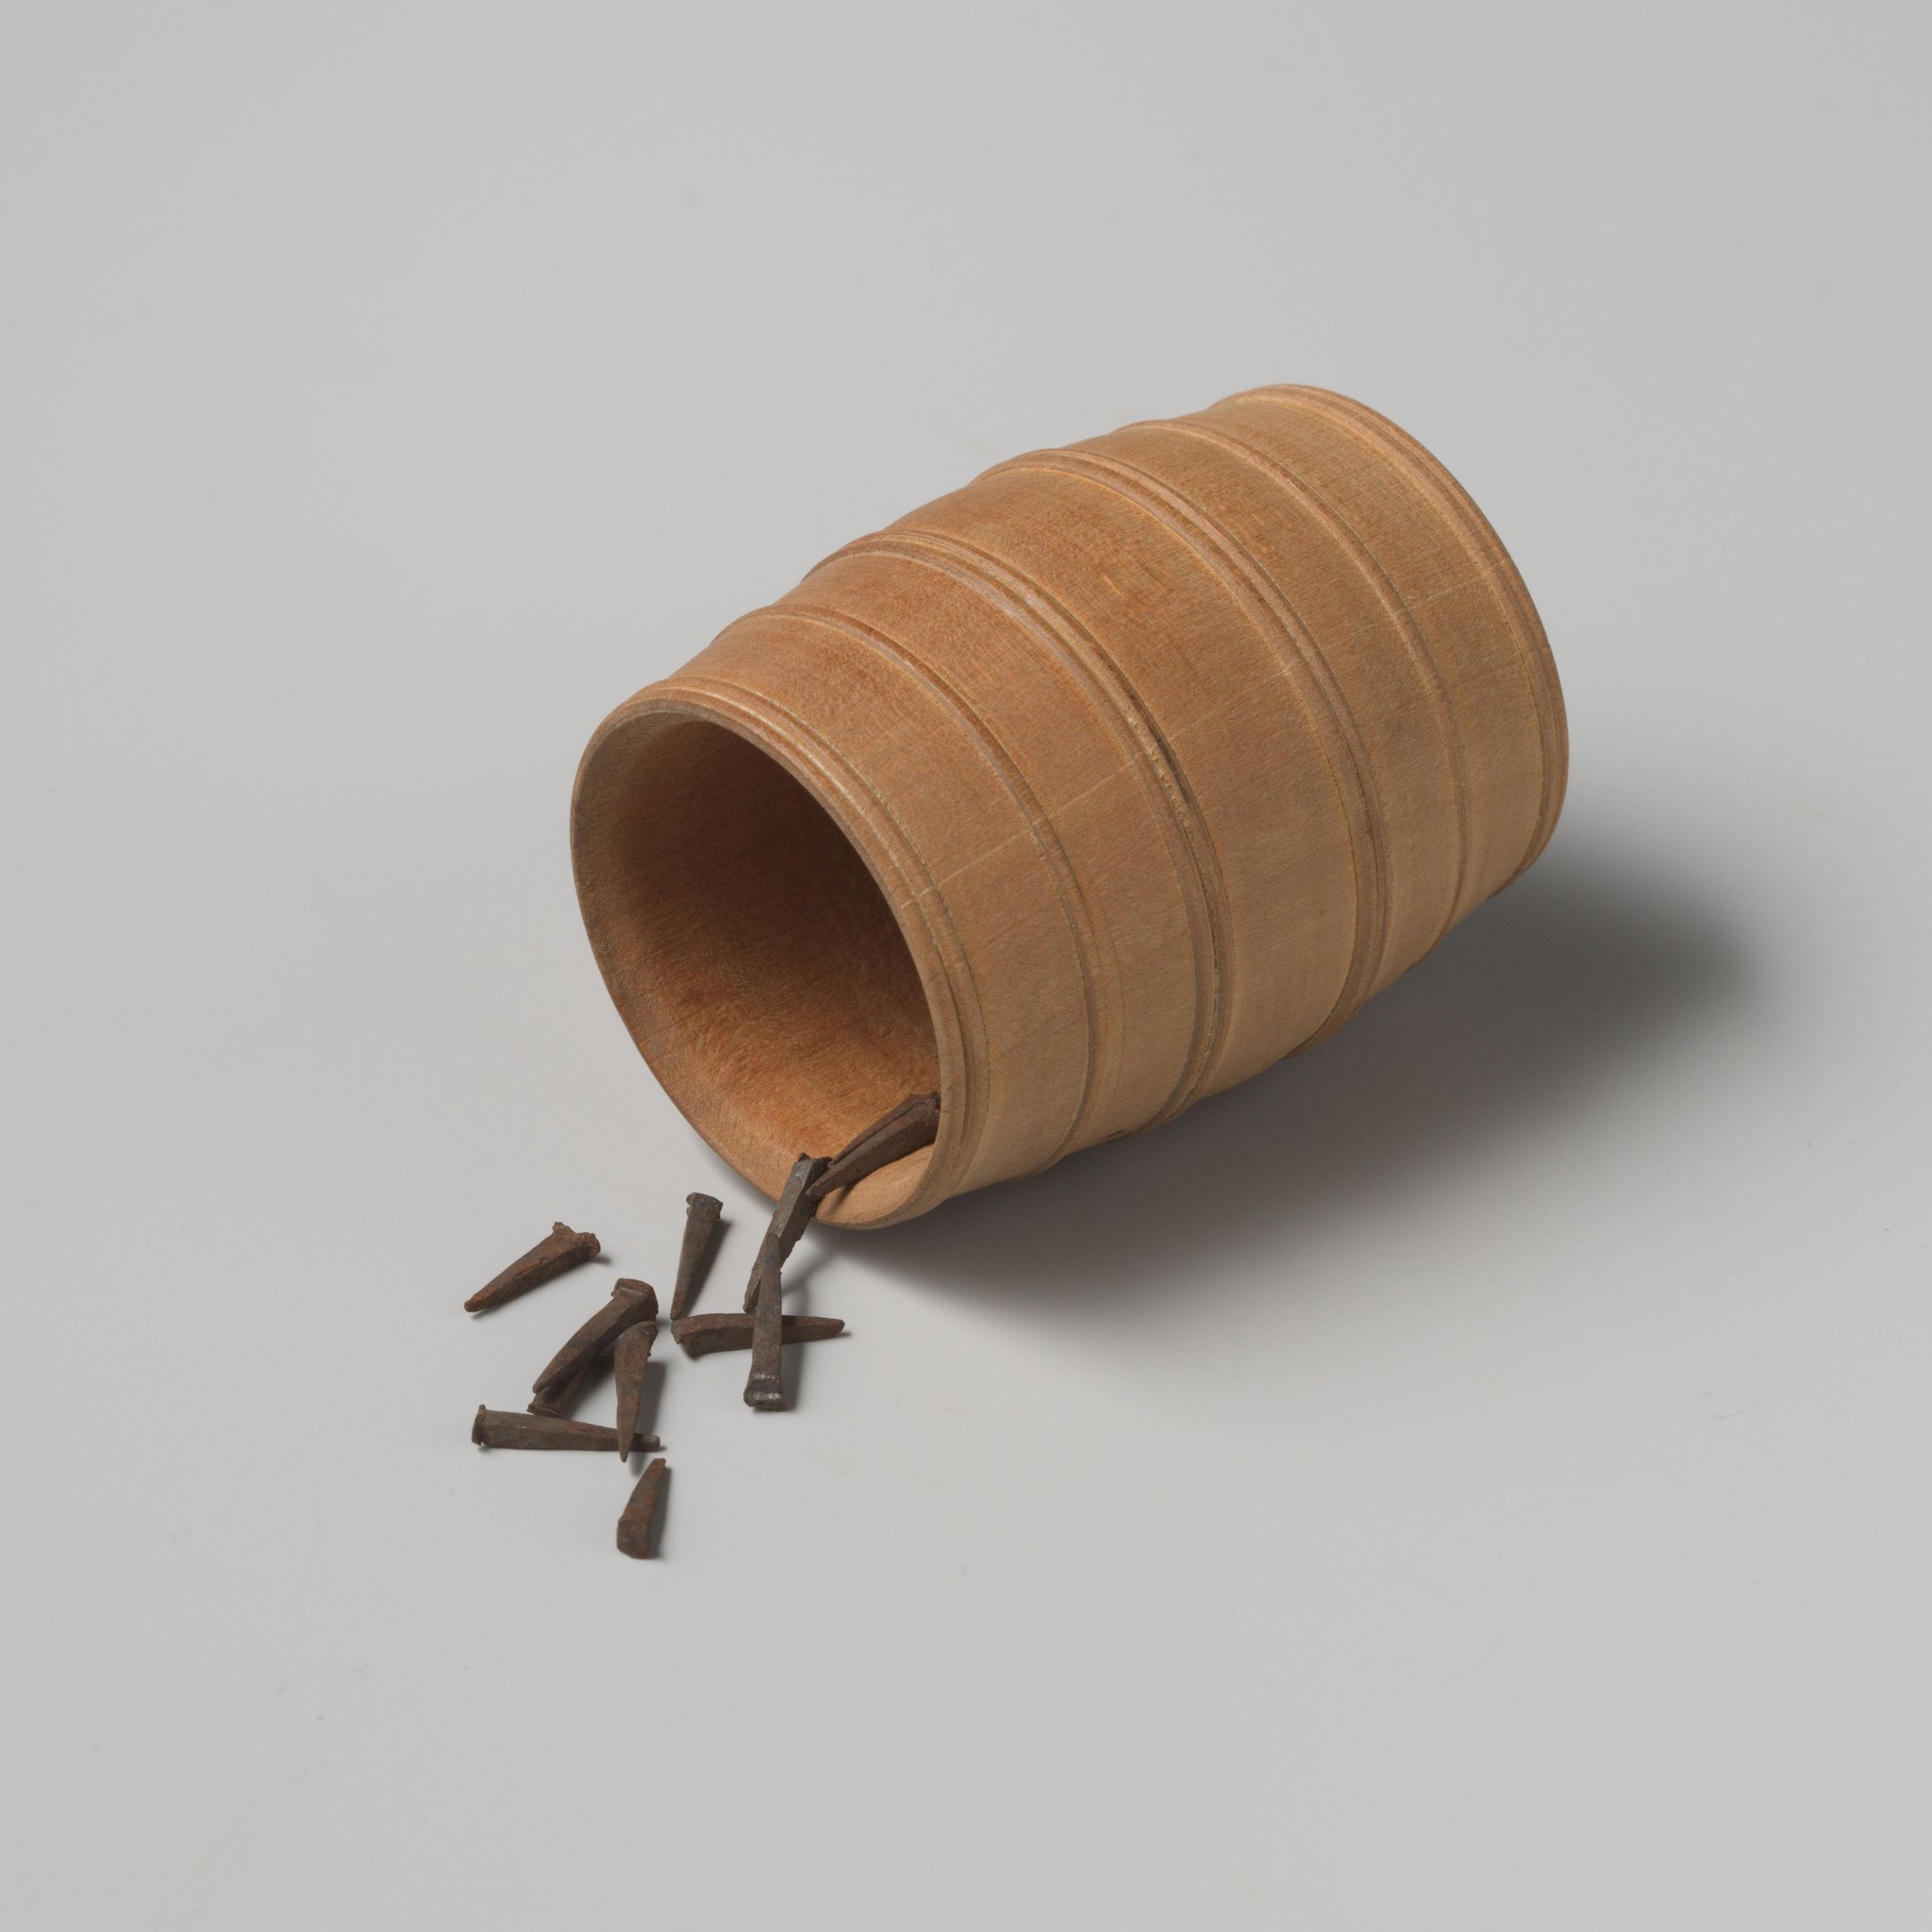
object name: miniature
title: Vat of ton, gedraaid van esdoornhout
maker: Anonymous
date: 1676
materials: wood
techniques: turning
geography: amsterdam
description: Vat of ton, gedraaid van esdoornhout met ringen, de hoepels voorstellende.